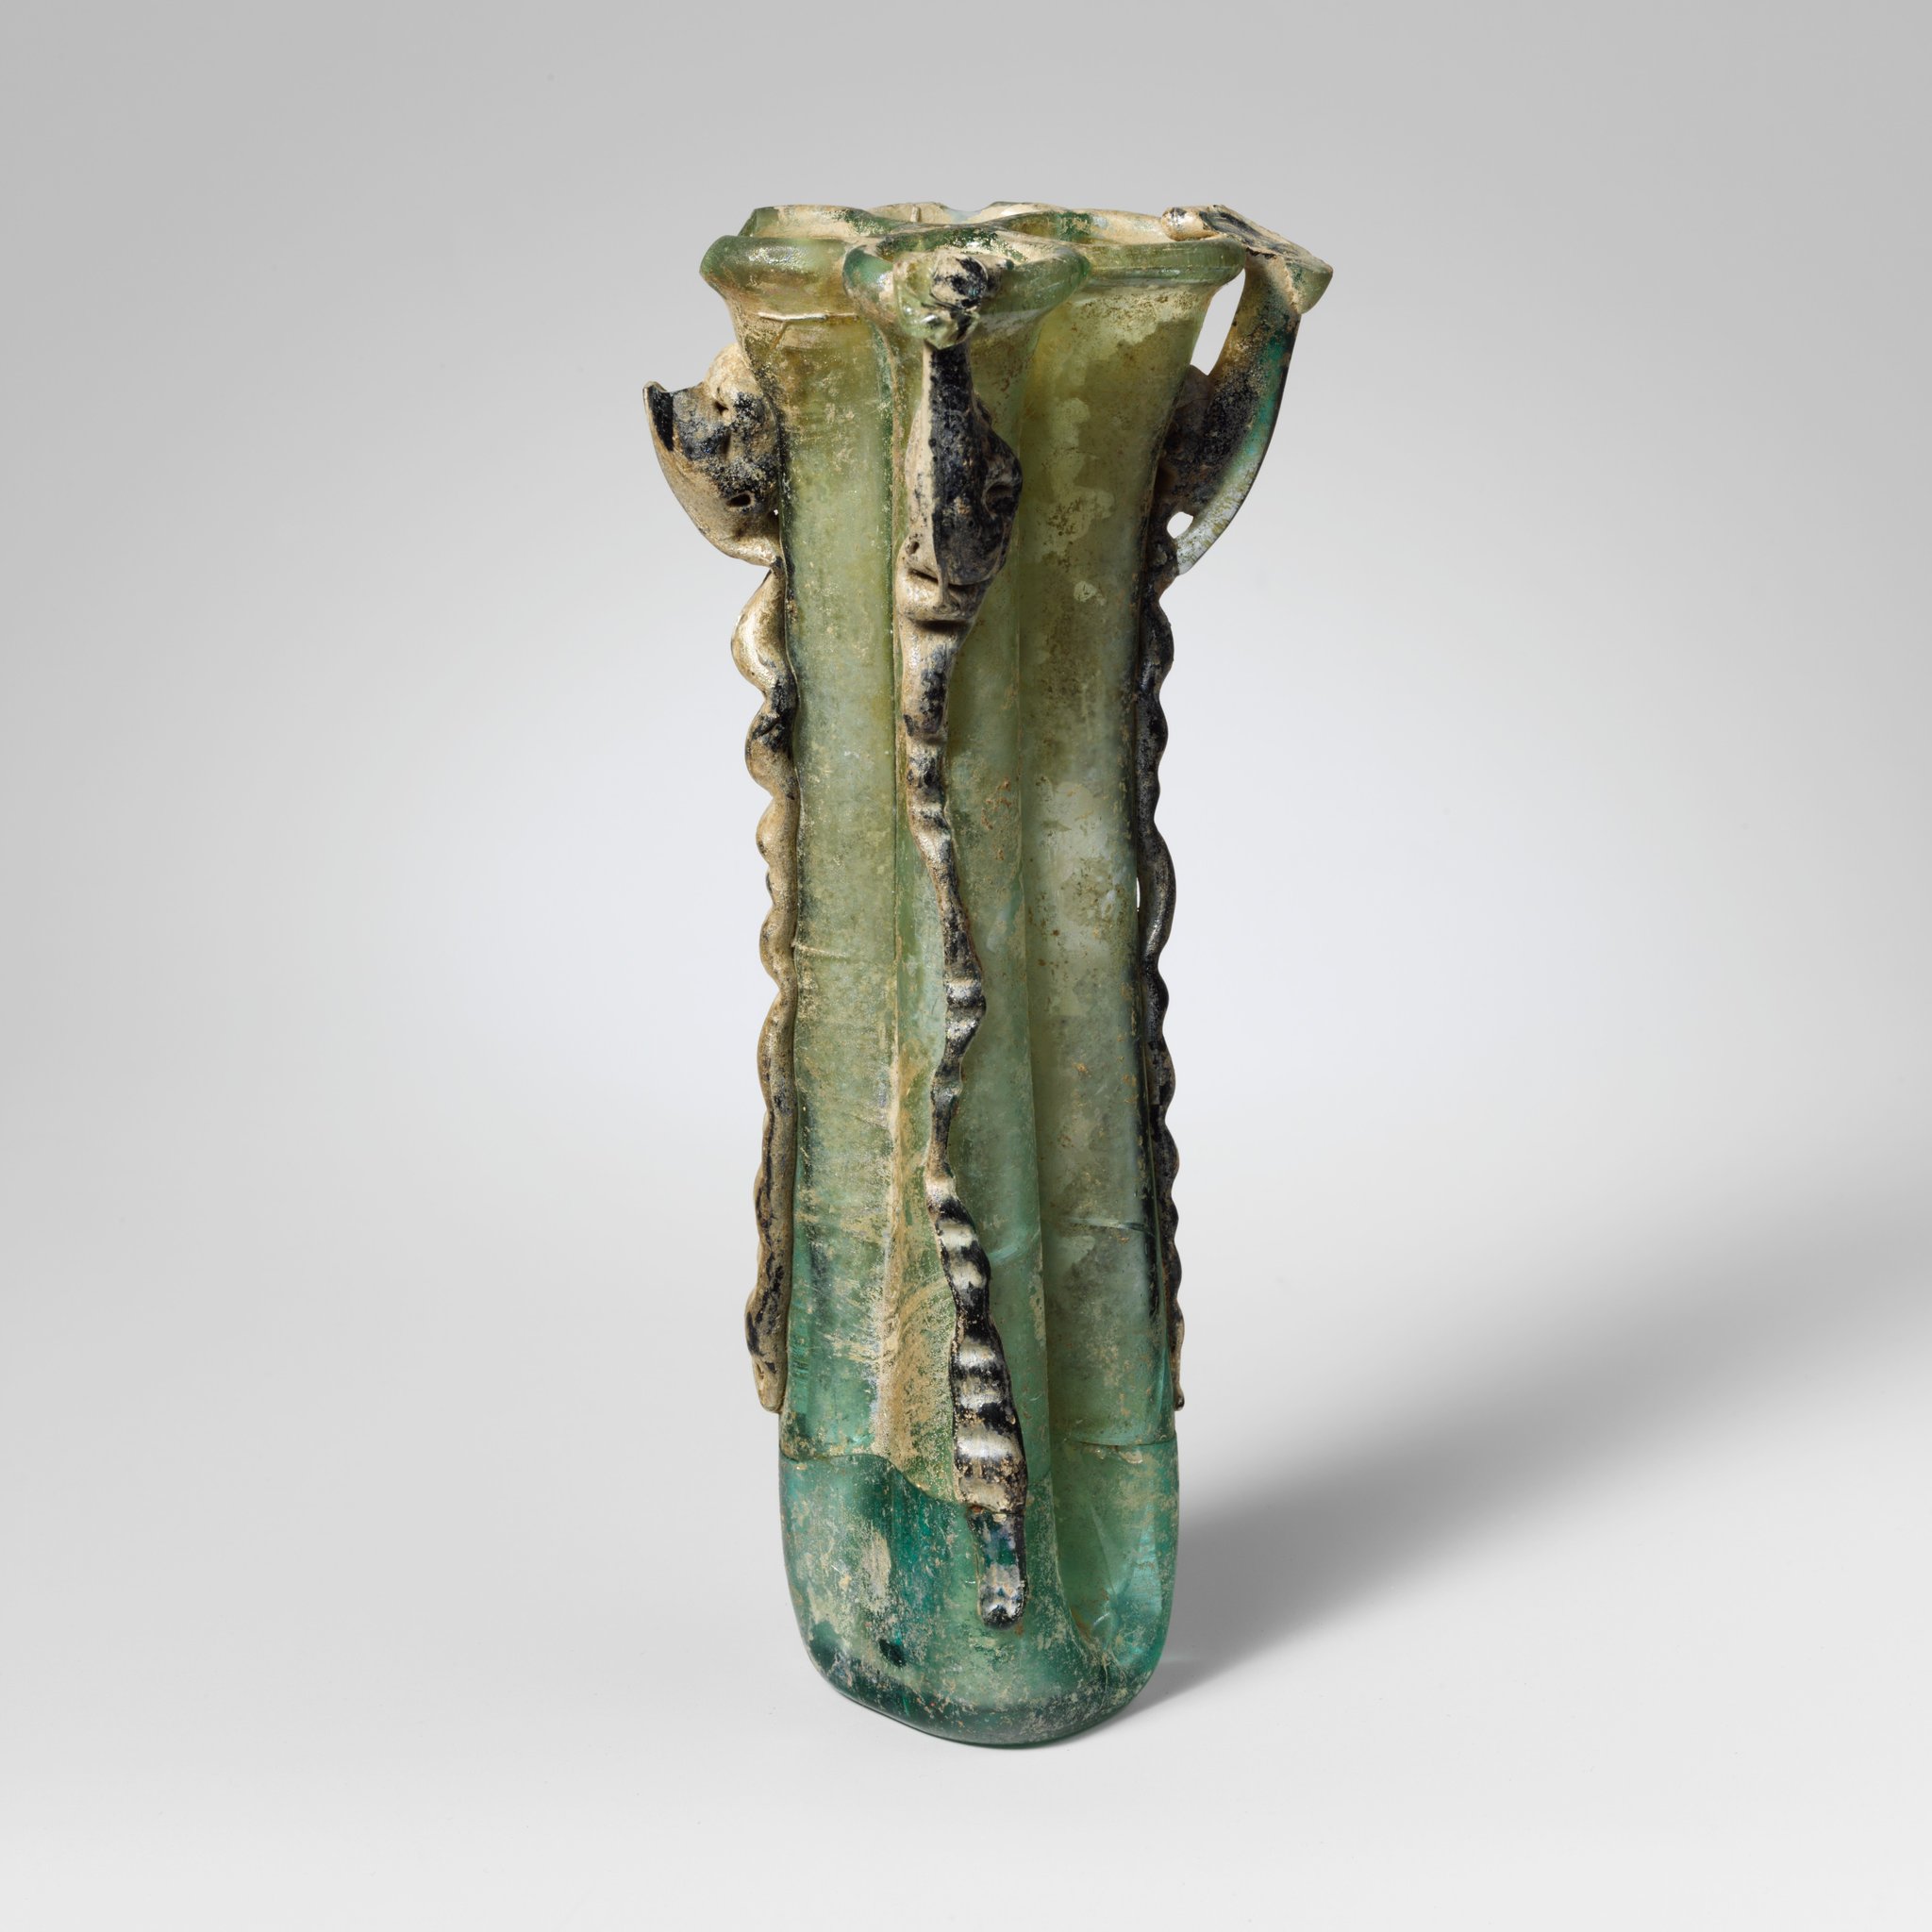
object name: cosmetic flask, single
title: Glass cosmetic flask with four compartments (kohl tube)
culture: roman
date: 301-500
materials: glass